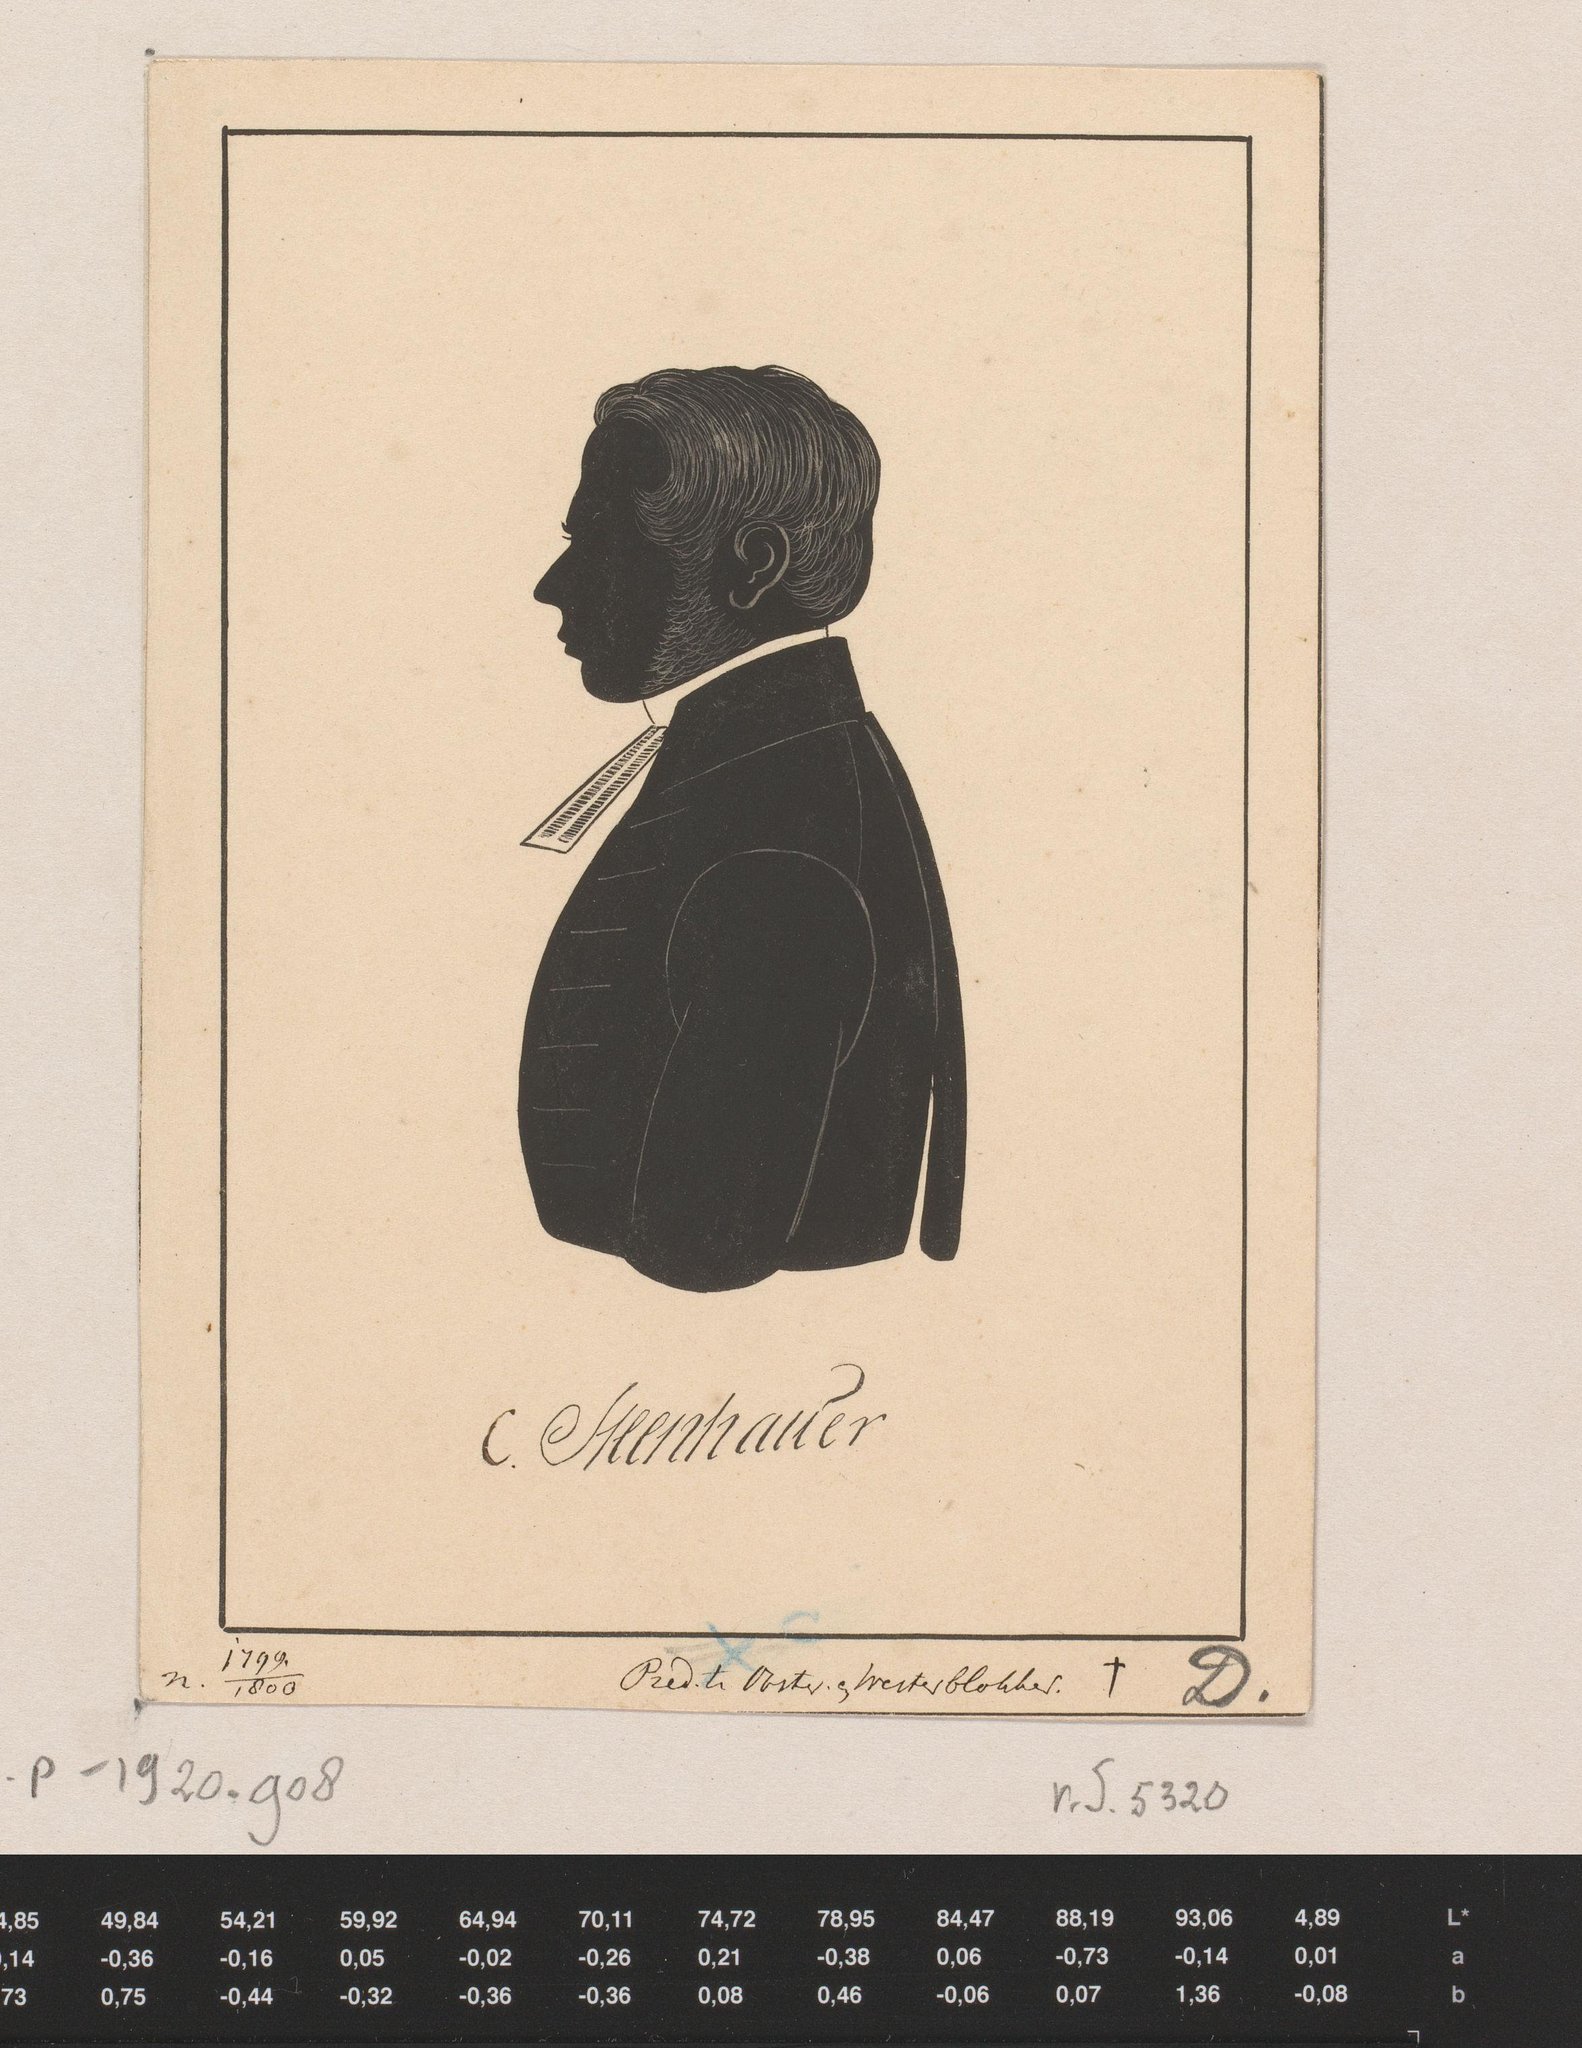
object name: print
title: Silhouetportret van Carel Steenhauer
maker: weduwe pieter barbiers (iv)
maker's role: publisher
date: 1818-1862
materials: paper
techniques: hand coloring, lithograph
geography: zwolle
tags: historical persons, functionaries and dignitaries ~ protestant churches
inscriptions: collector's mark: Lugt 2228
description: Met facsimile handtekening van de geportretteerde.